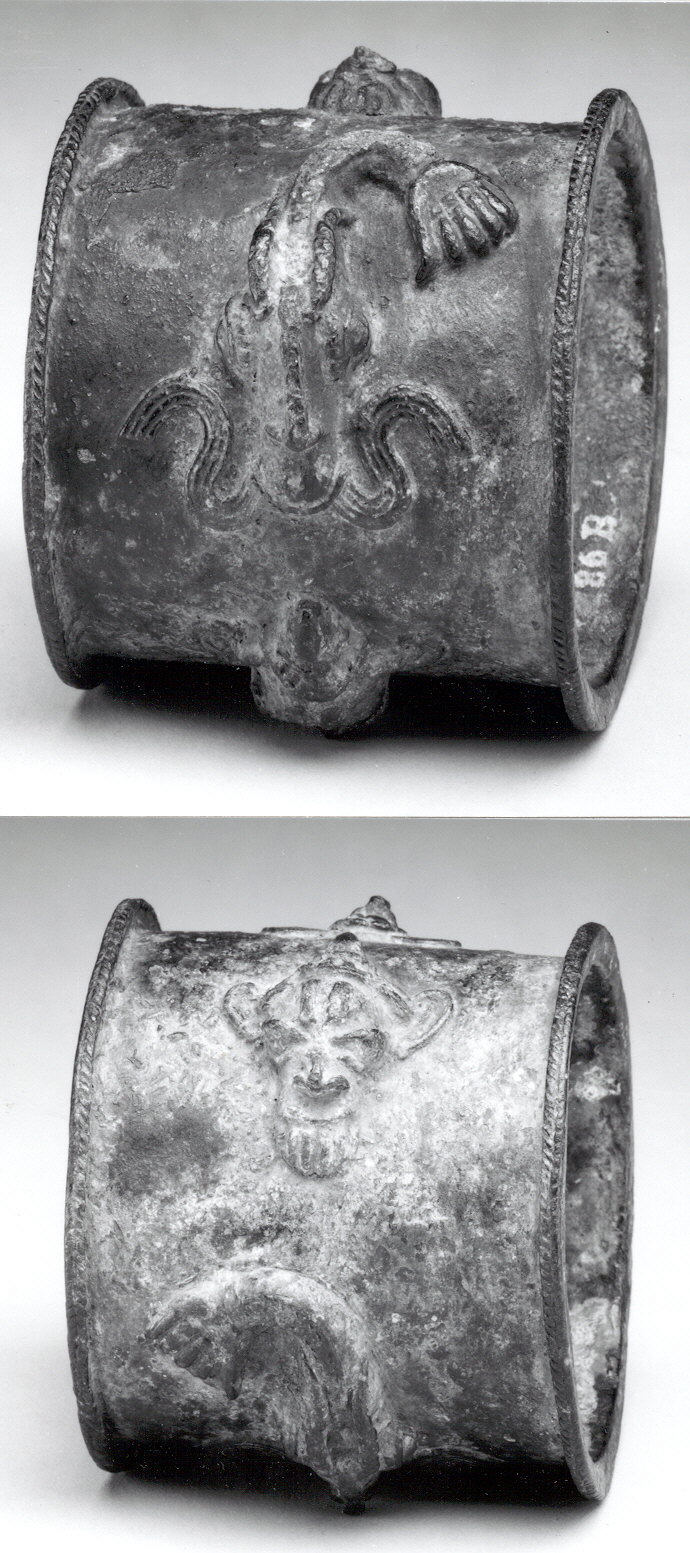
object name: bracelet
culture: yoruba peoples, ijebu group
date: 1701-1800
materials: brass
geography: nigeria